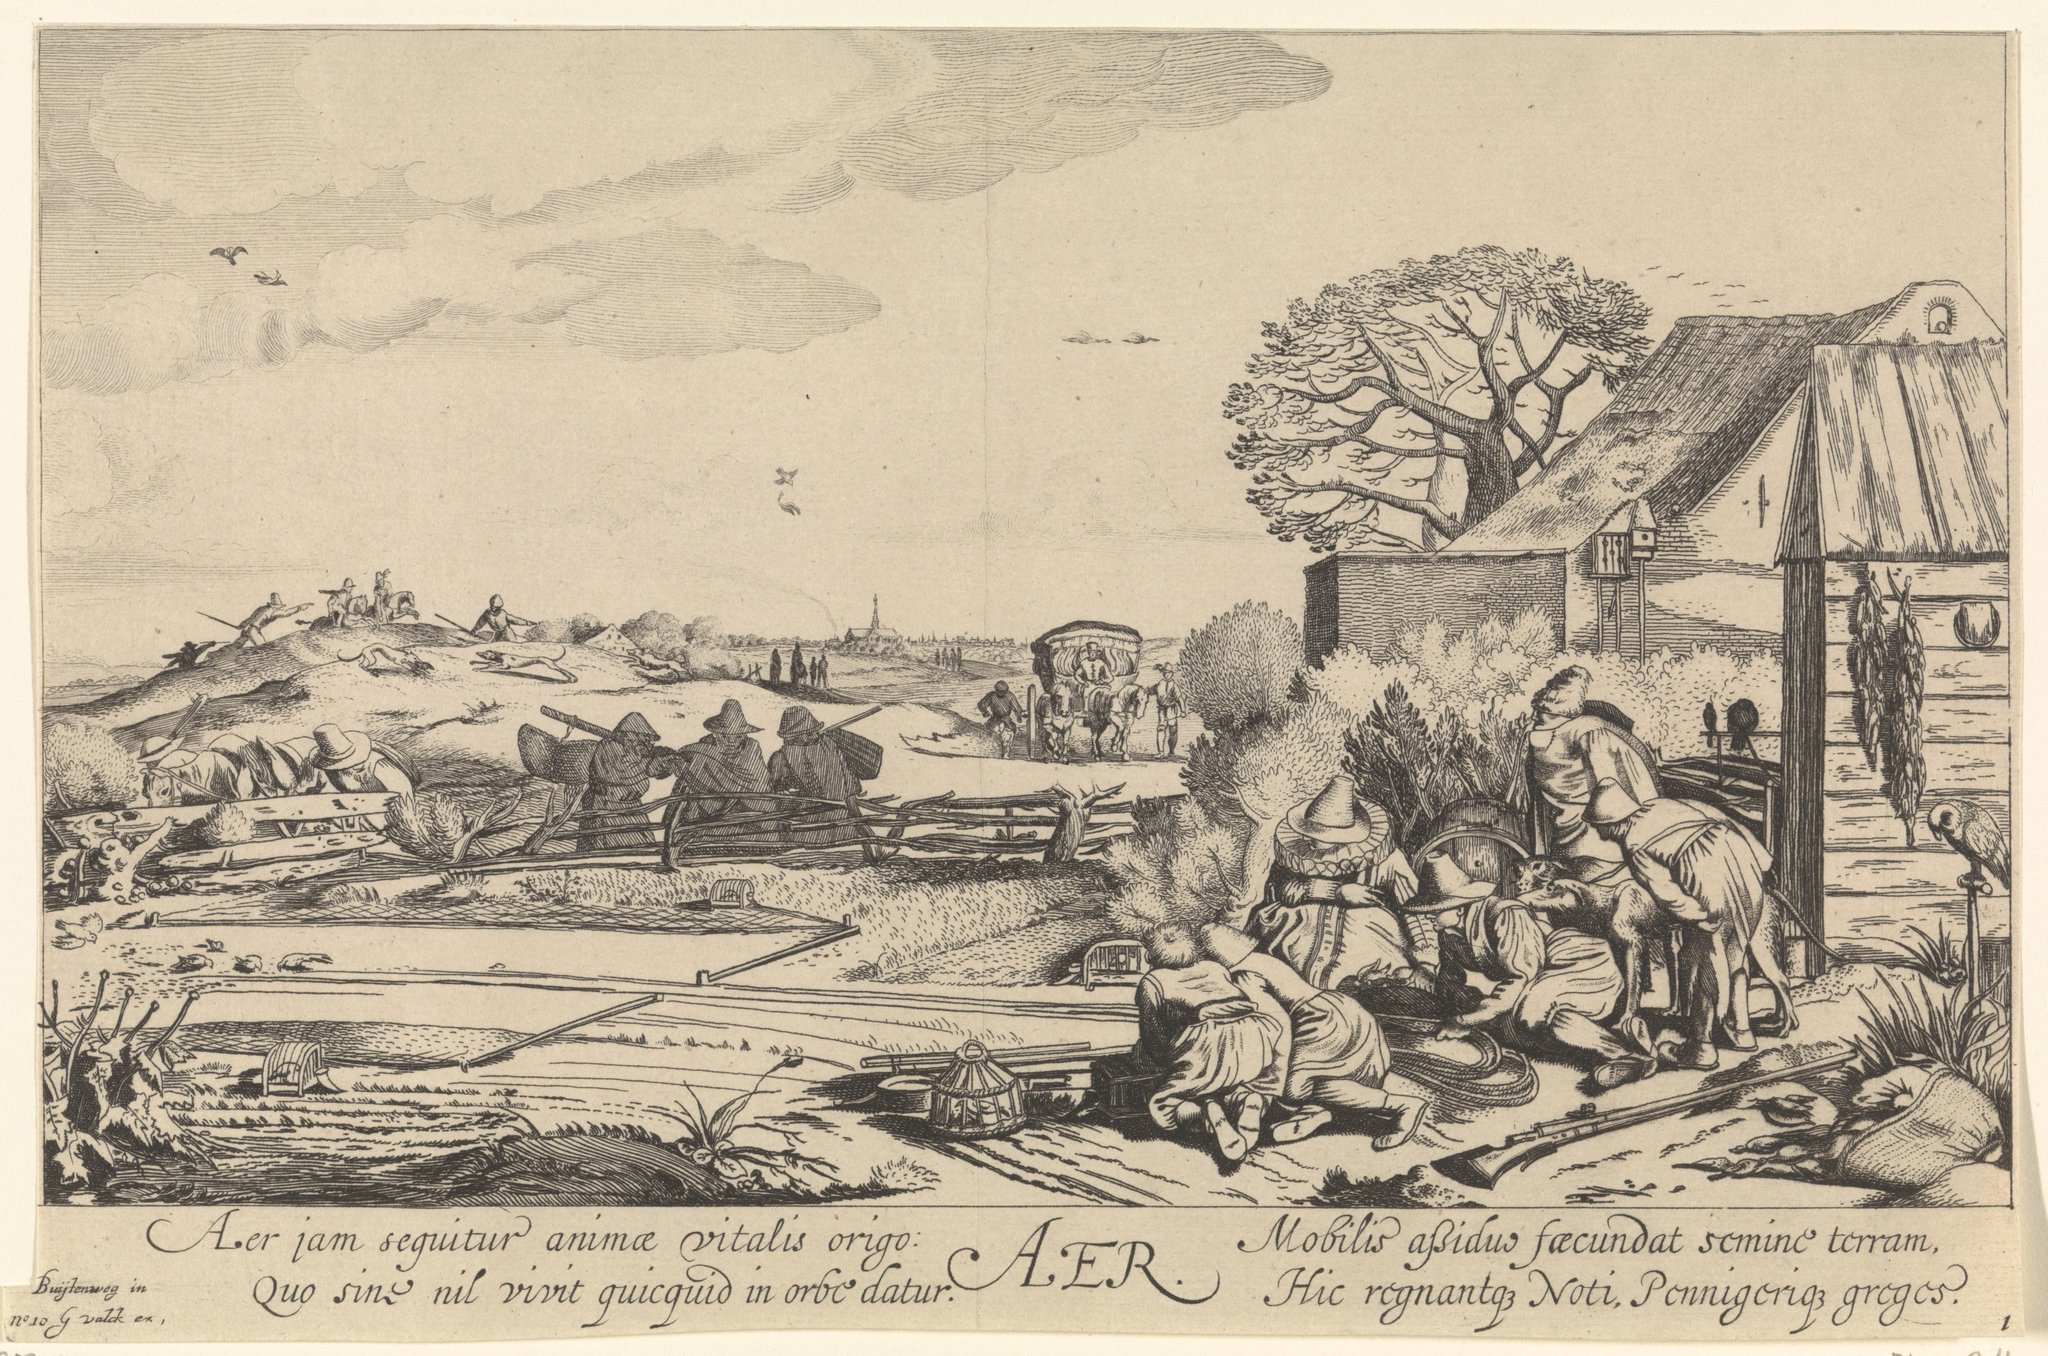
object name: print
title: Lucht (Aer)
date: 1622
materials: paper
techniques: engraving, etching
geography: amsterdam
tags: air (one of the four elements), bird hunting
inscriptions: collector's mark: Lugt 2228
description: Een landschap met figuren die op vogels jagen, voorstellende het element lucht: Zittende figuren houden hun vogelvangen in de gaten op het land. Op de achtergrond een valkenjacht. Eerste prent uit een serie van vier met landschappen als verbeeldingen van de vier elementen.